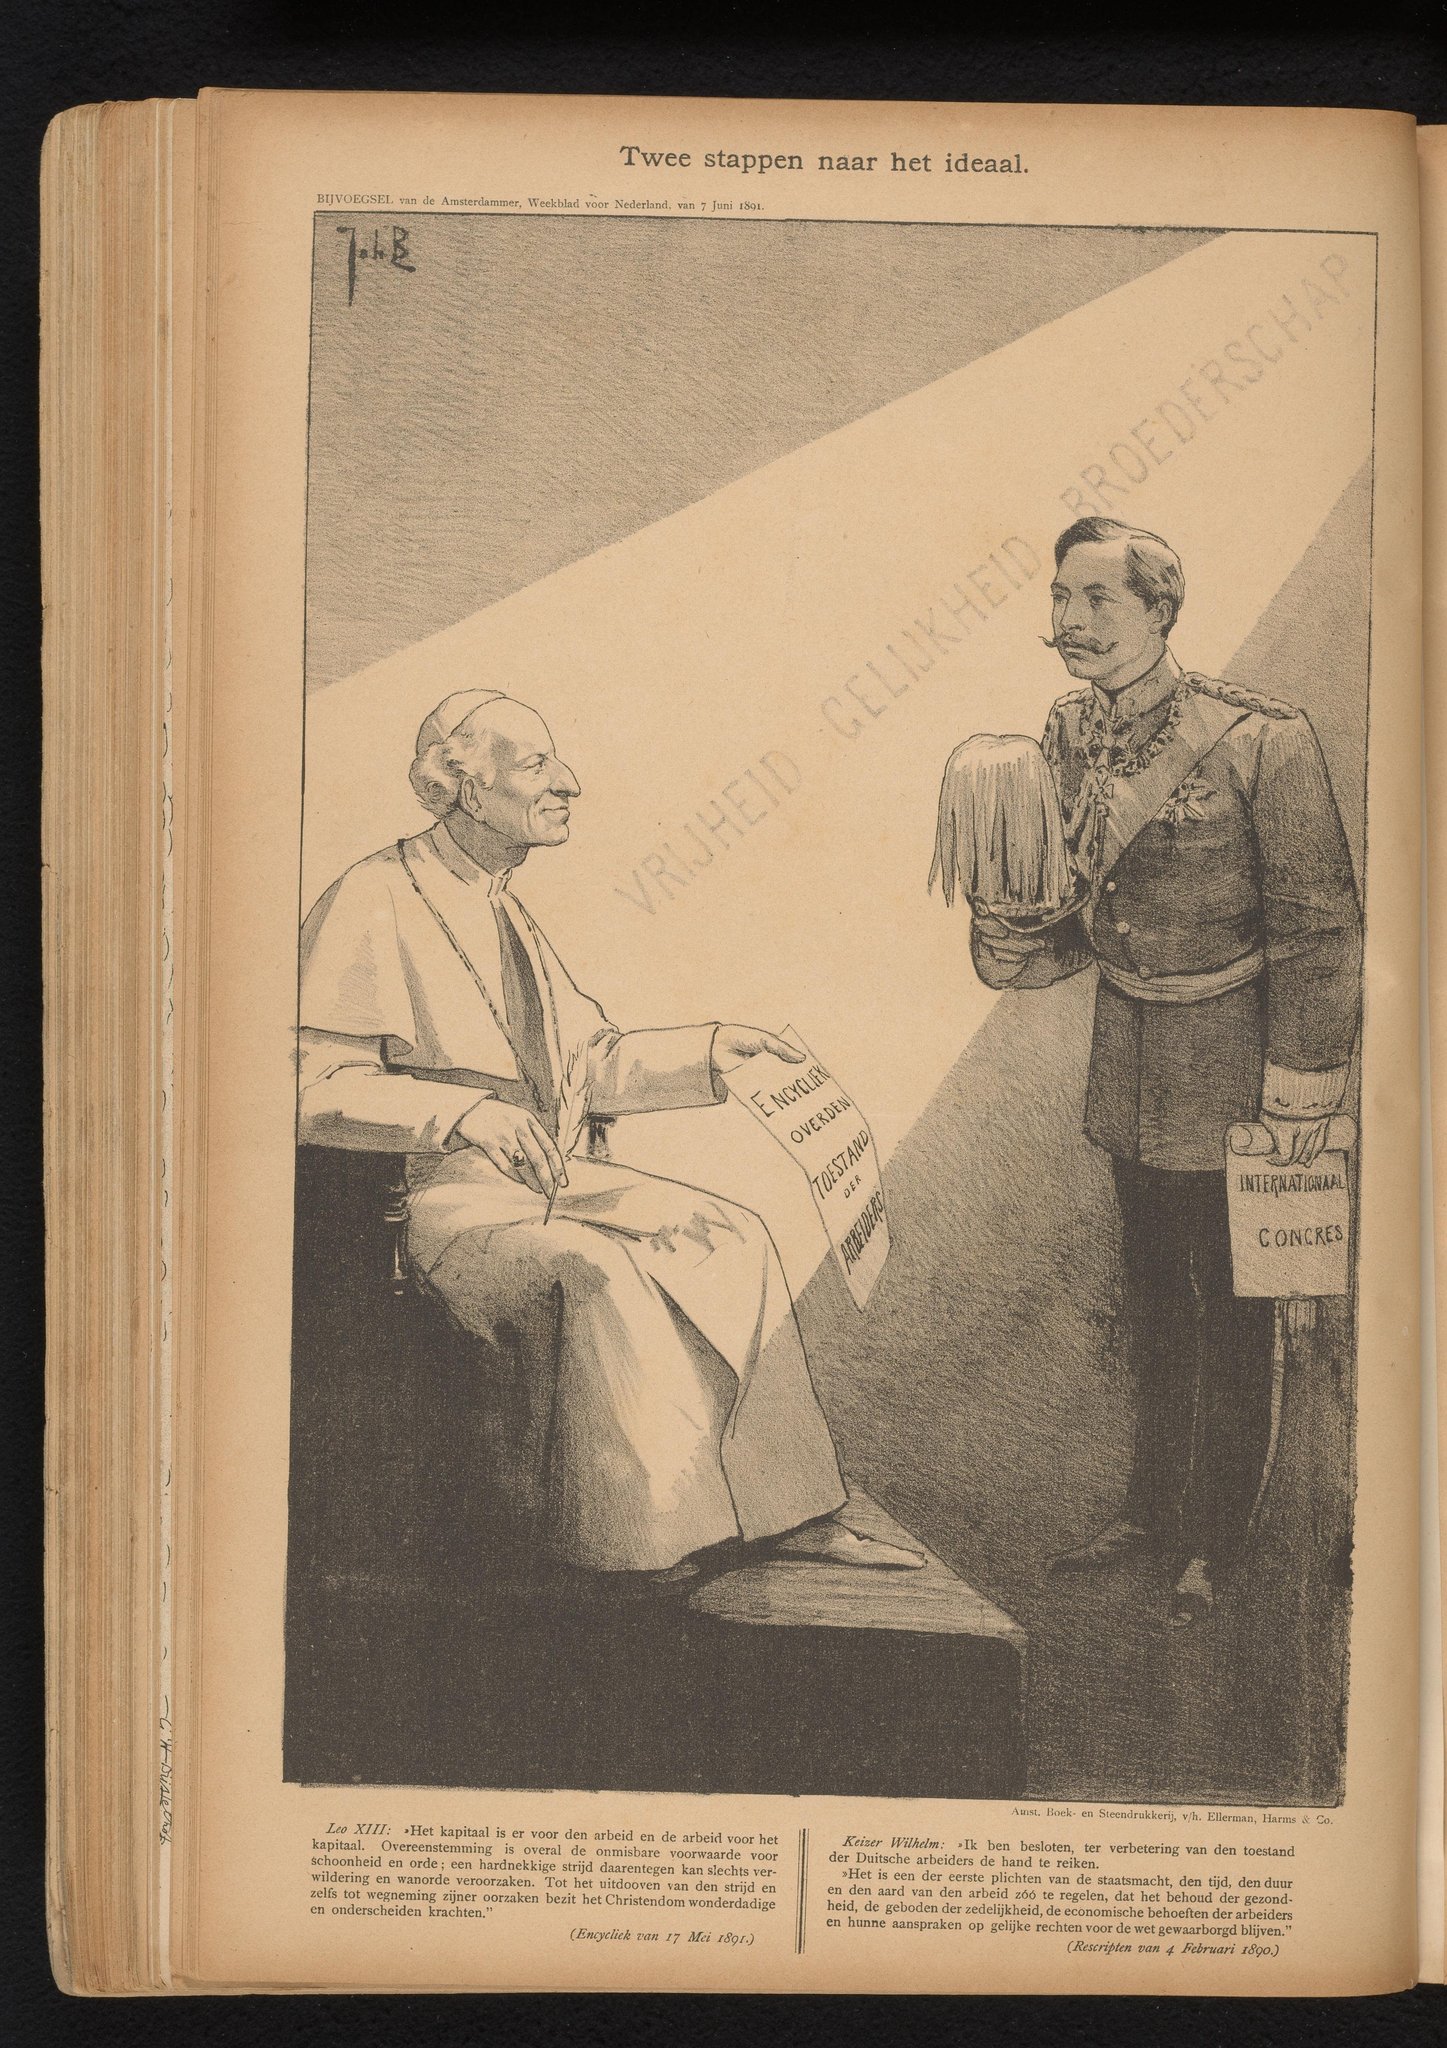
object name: cartoon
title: Twee stappen naar het ideaal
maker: johan braakensiek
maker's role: draughtsman, print maker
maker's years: 1858-1940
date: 1891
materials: paper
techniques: lithograph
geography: amsterdam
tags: wilhelm ii (keizer van duitsland), rome, leo xiii, working class, labourers, political caricatures and satires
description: De Duitse keizer Wilhelm II en paus Leo XIII in overeenstemming over meer rechten en betere werkomstandigheden voor de arbeiders.